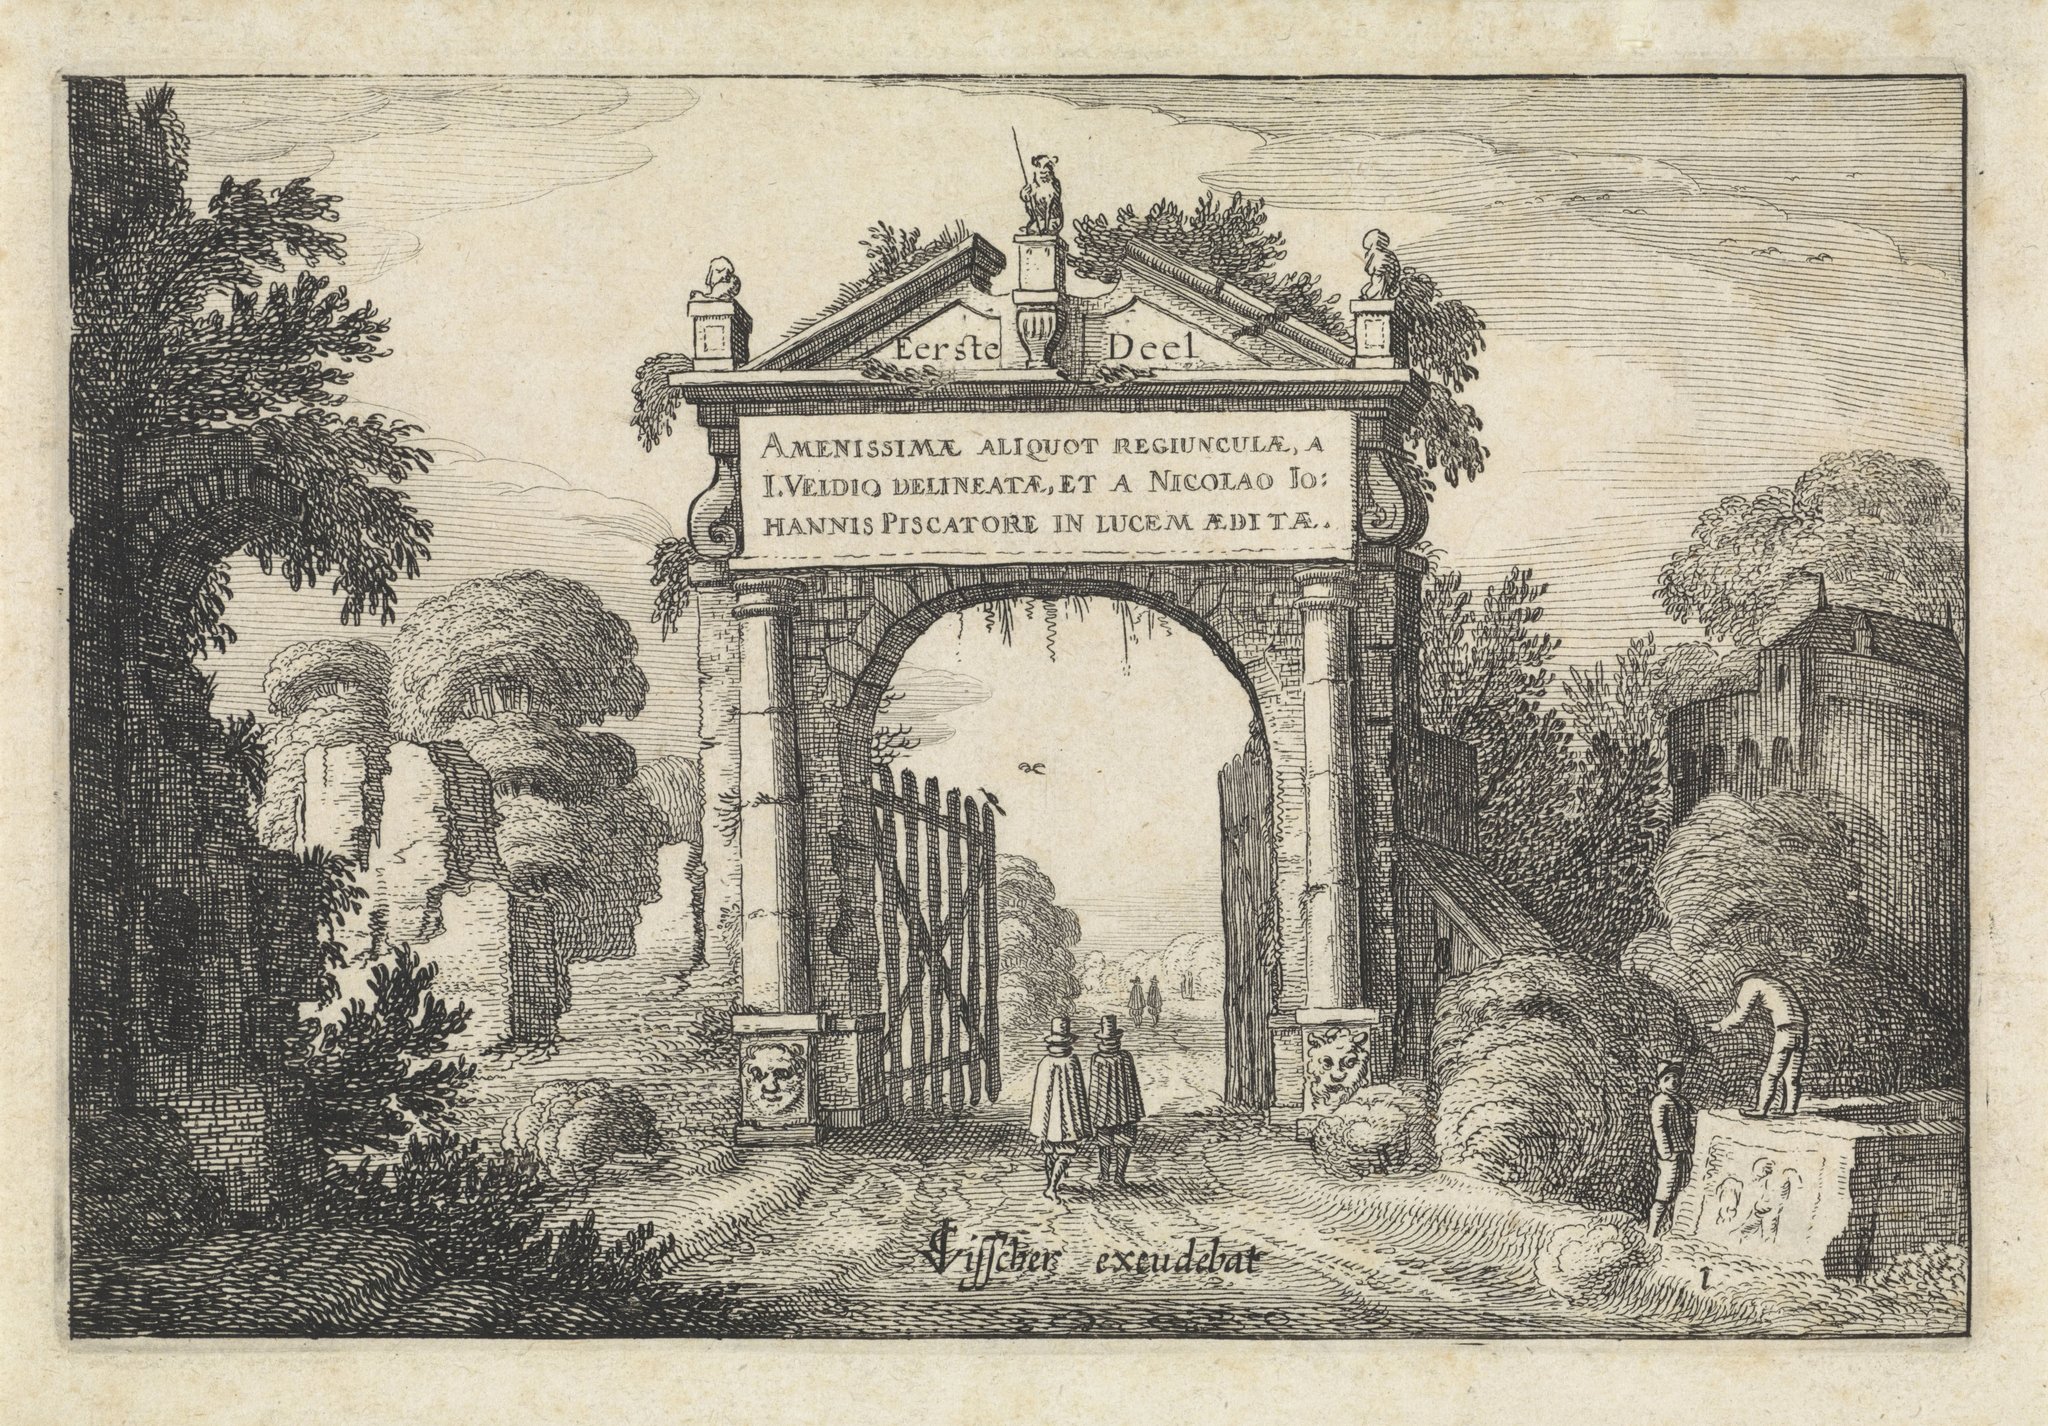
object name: print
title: Amenissimae aliquot requculae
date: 1616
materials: paper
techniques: etching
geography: northern netherlands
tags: landscape with ruins, landscape with monument, gate, entrance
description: Oorspronkelijk vormden de eerste staten van de prenten een serie bestaande uit twee delen van elk 26 prenten. De latere staten vormden een serie van vijf delen van elk twaalf prenten.